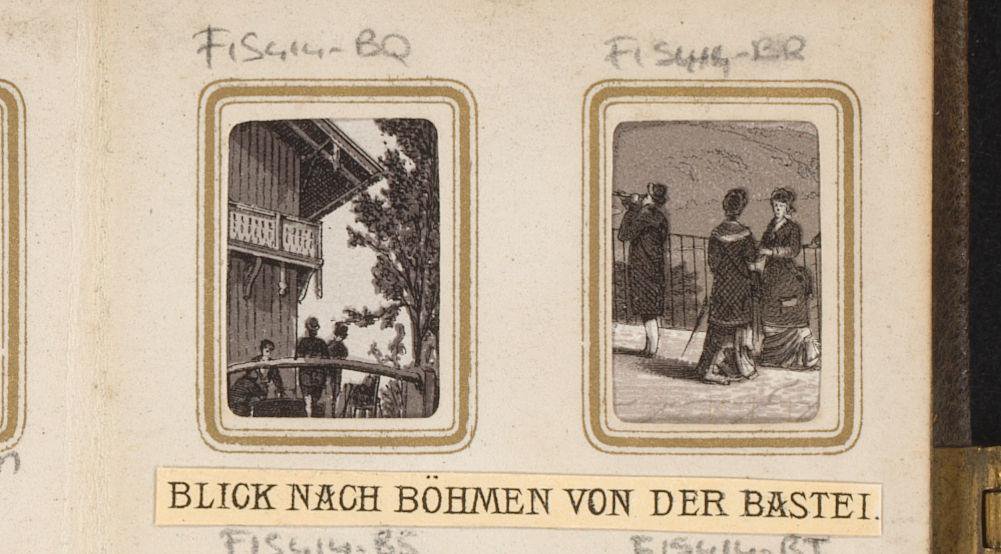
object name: print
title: Uitkijkpunt op de Bastei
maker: Anonymous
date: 1851-1910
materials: paper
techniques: lithograph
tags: city-view, and landscape with man-made constructions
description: Deze prent maakt deel uit van een album.